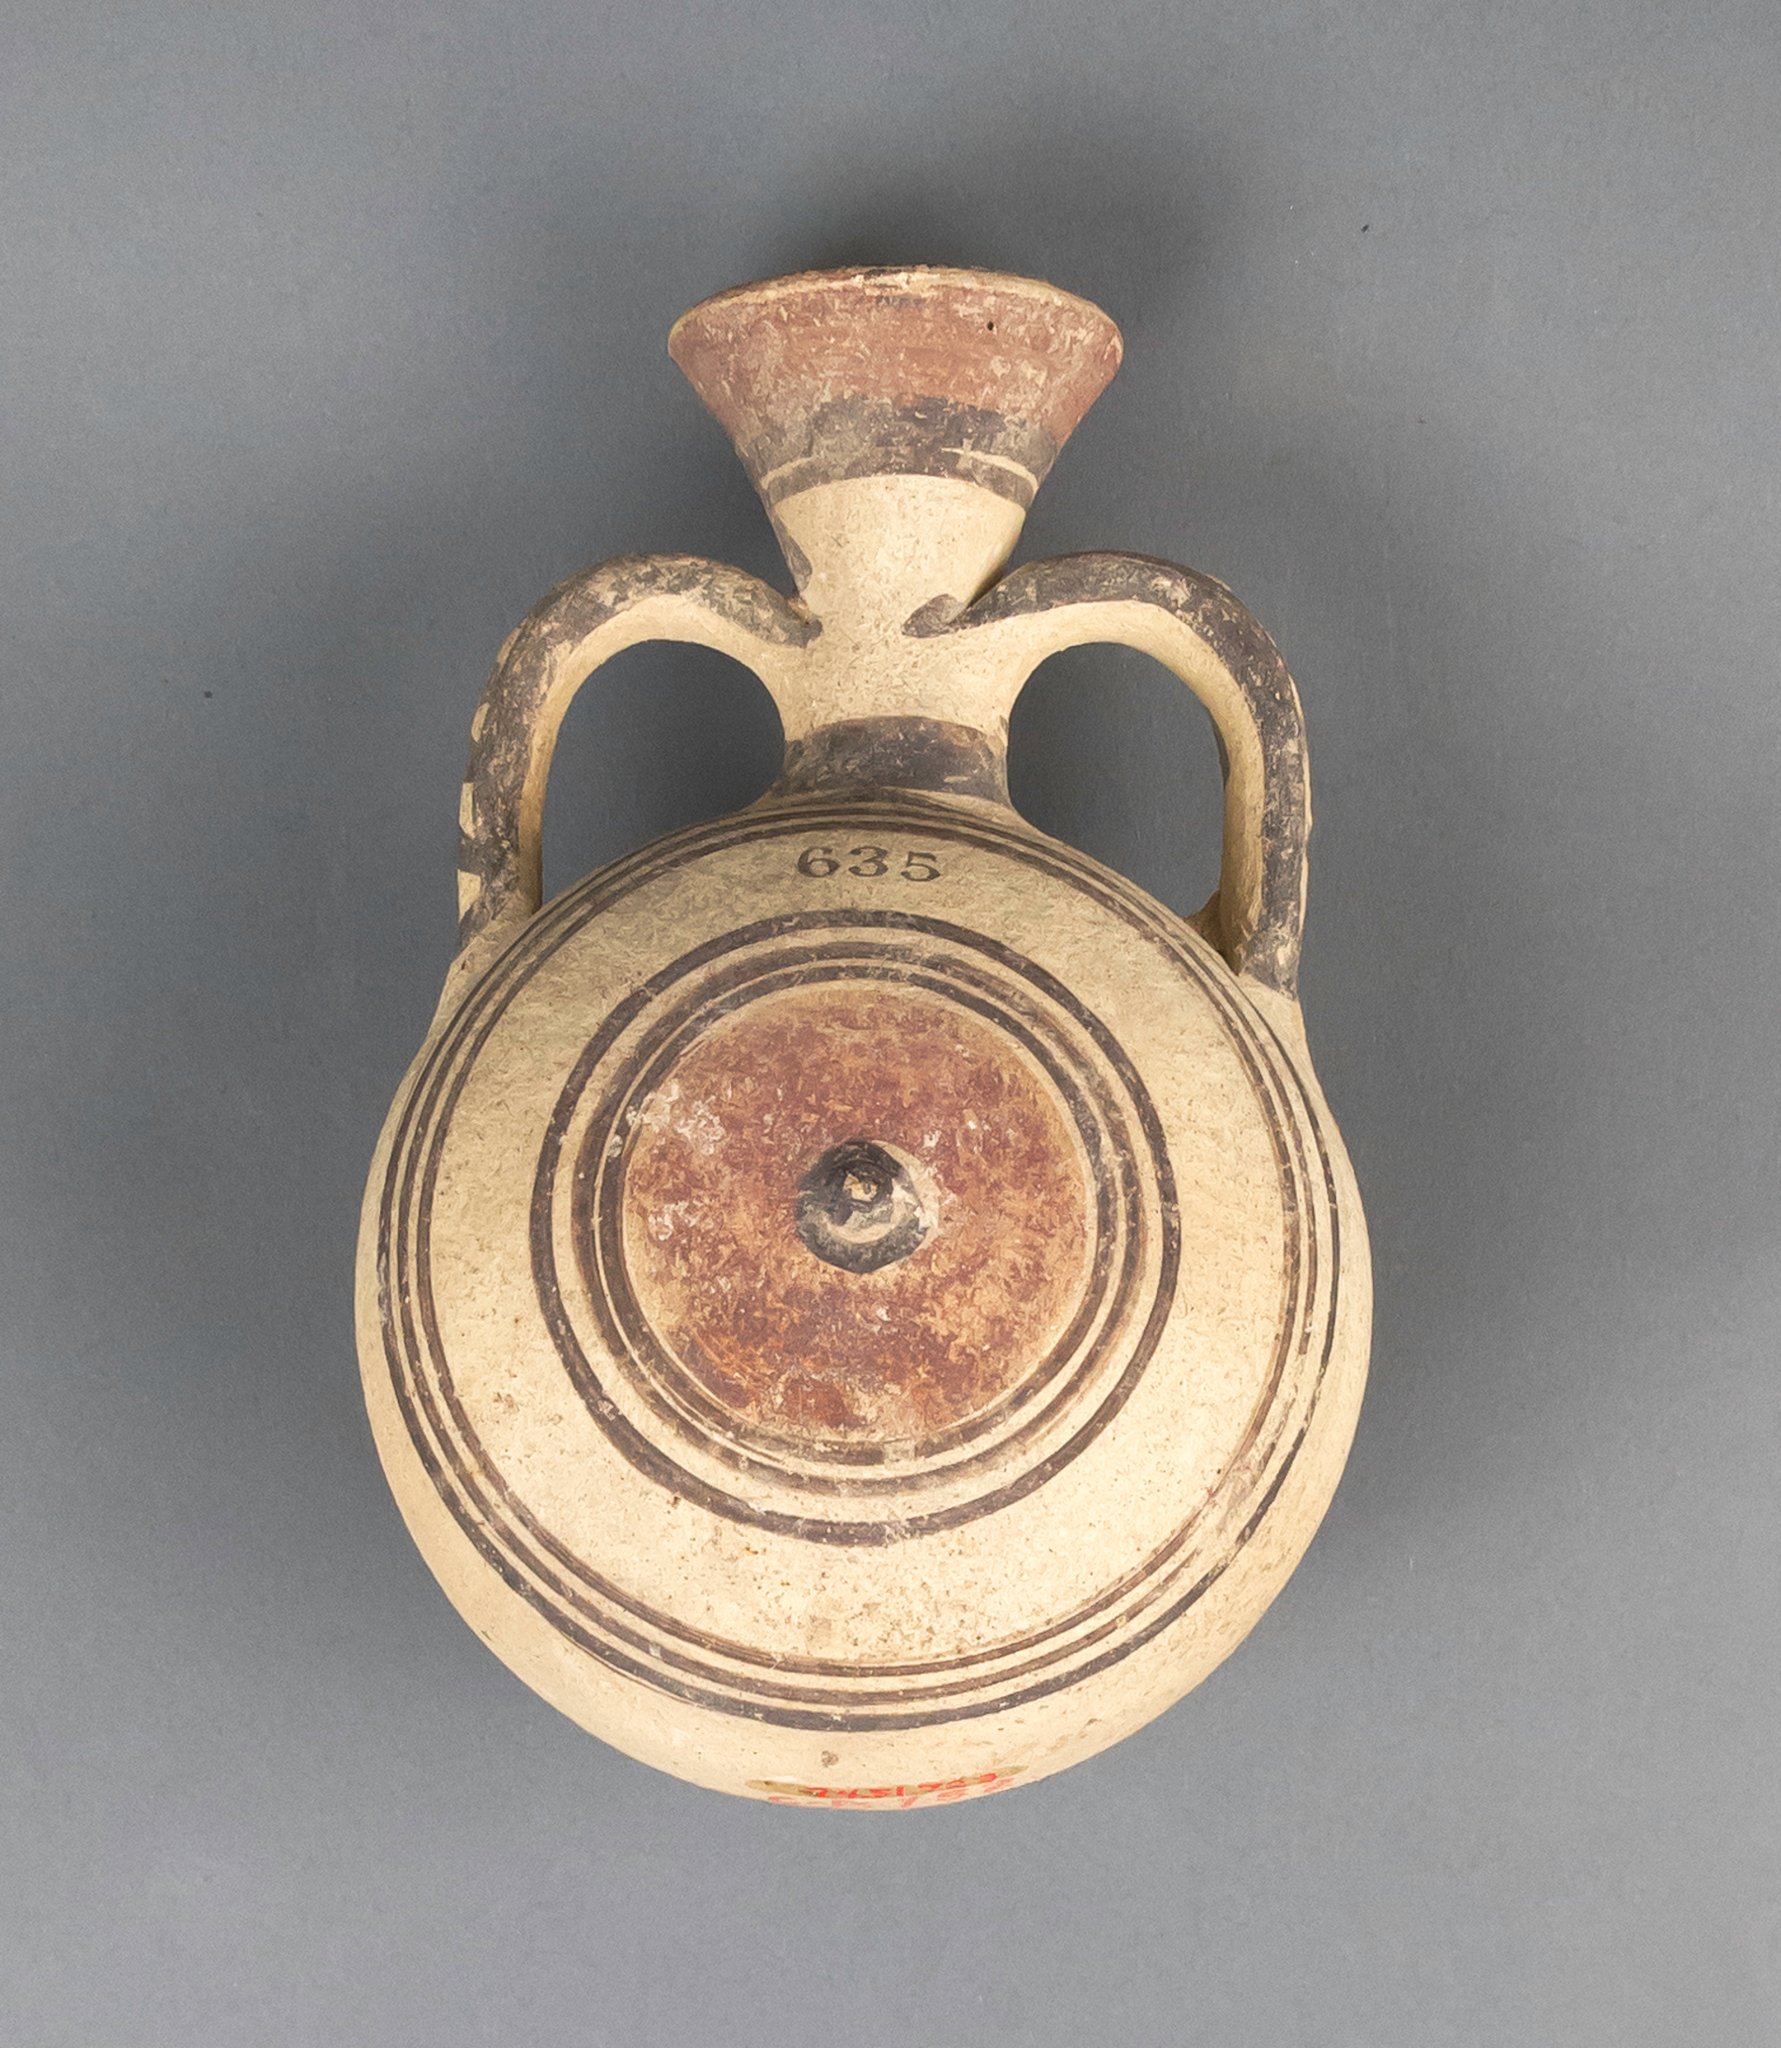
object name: flask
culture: cypriot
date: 850-750 BCE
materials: terracotta